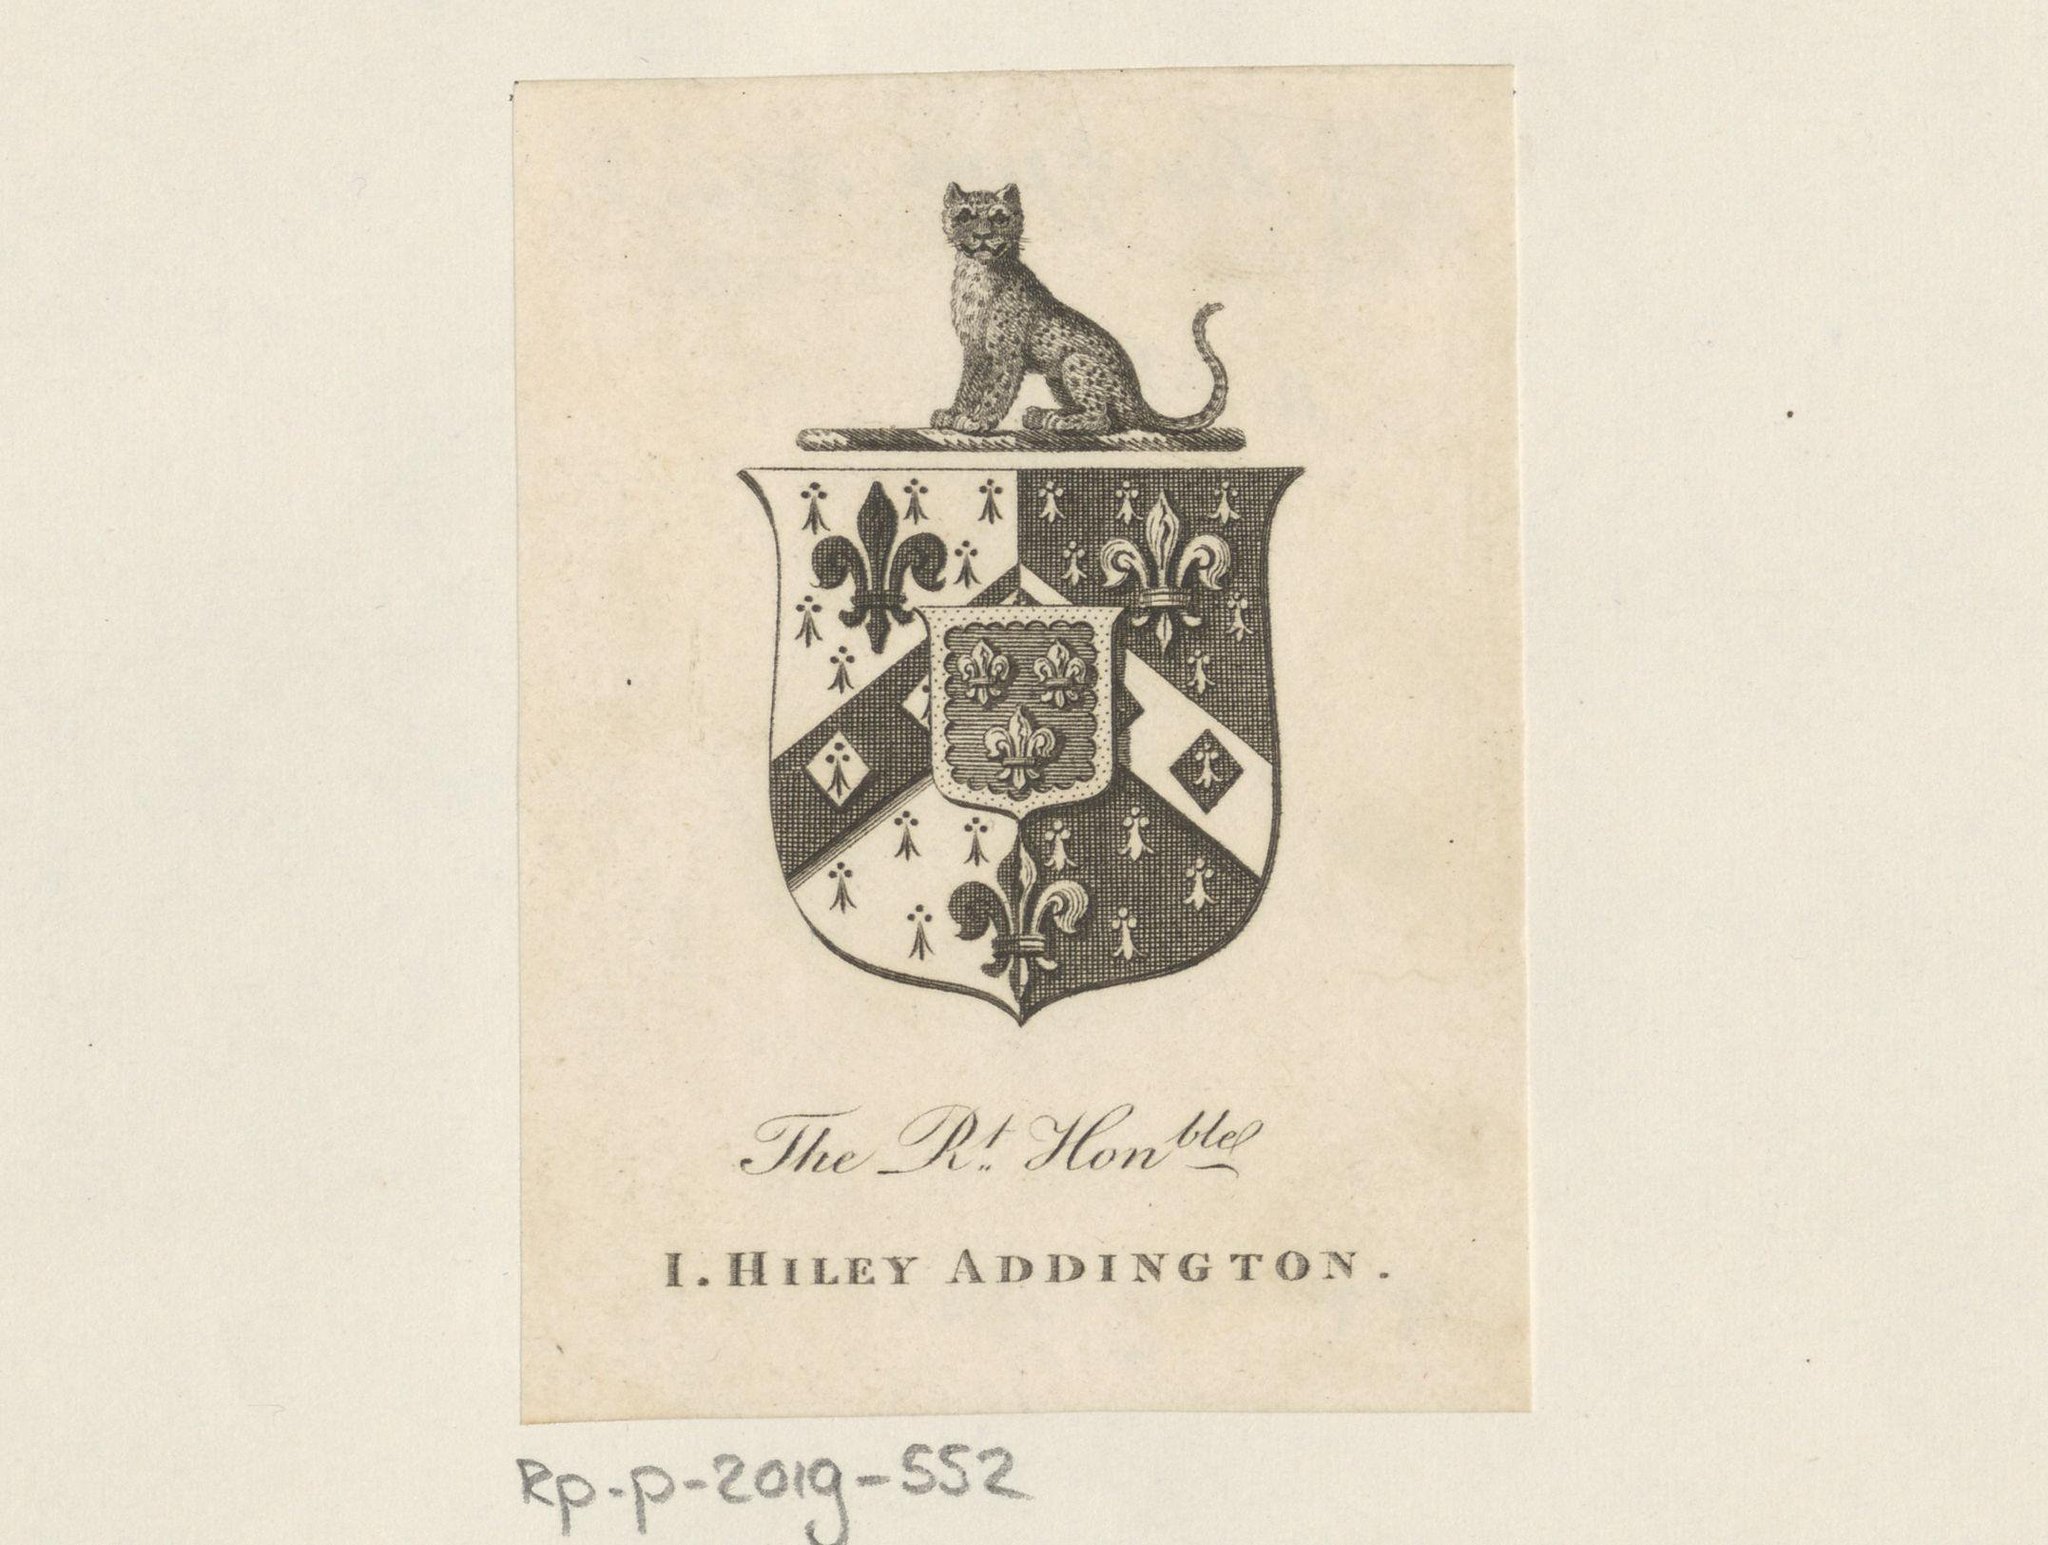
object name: bookplate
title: Ex libris van I. Hiley Addington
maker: Anonymous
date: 1785-1818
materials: paper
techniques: etching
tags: politician, armorial bearing, heraldry